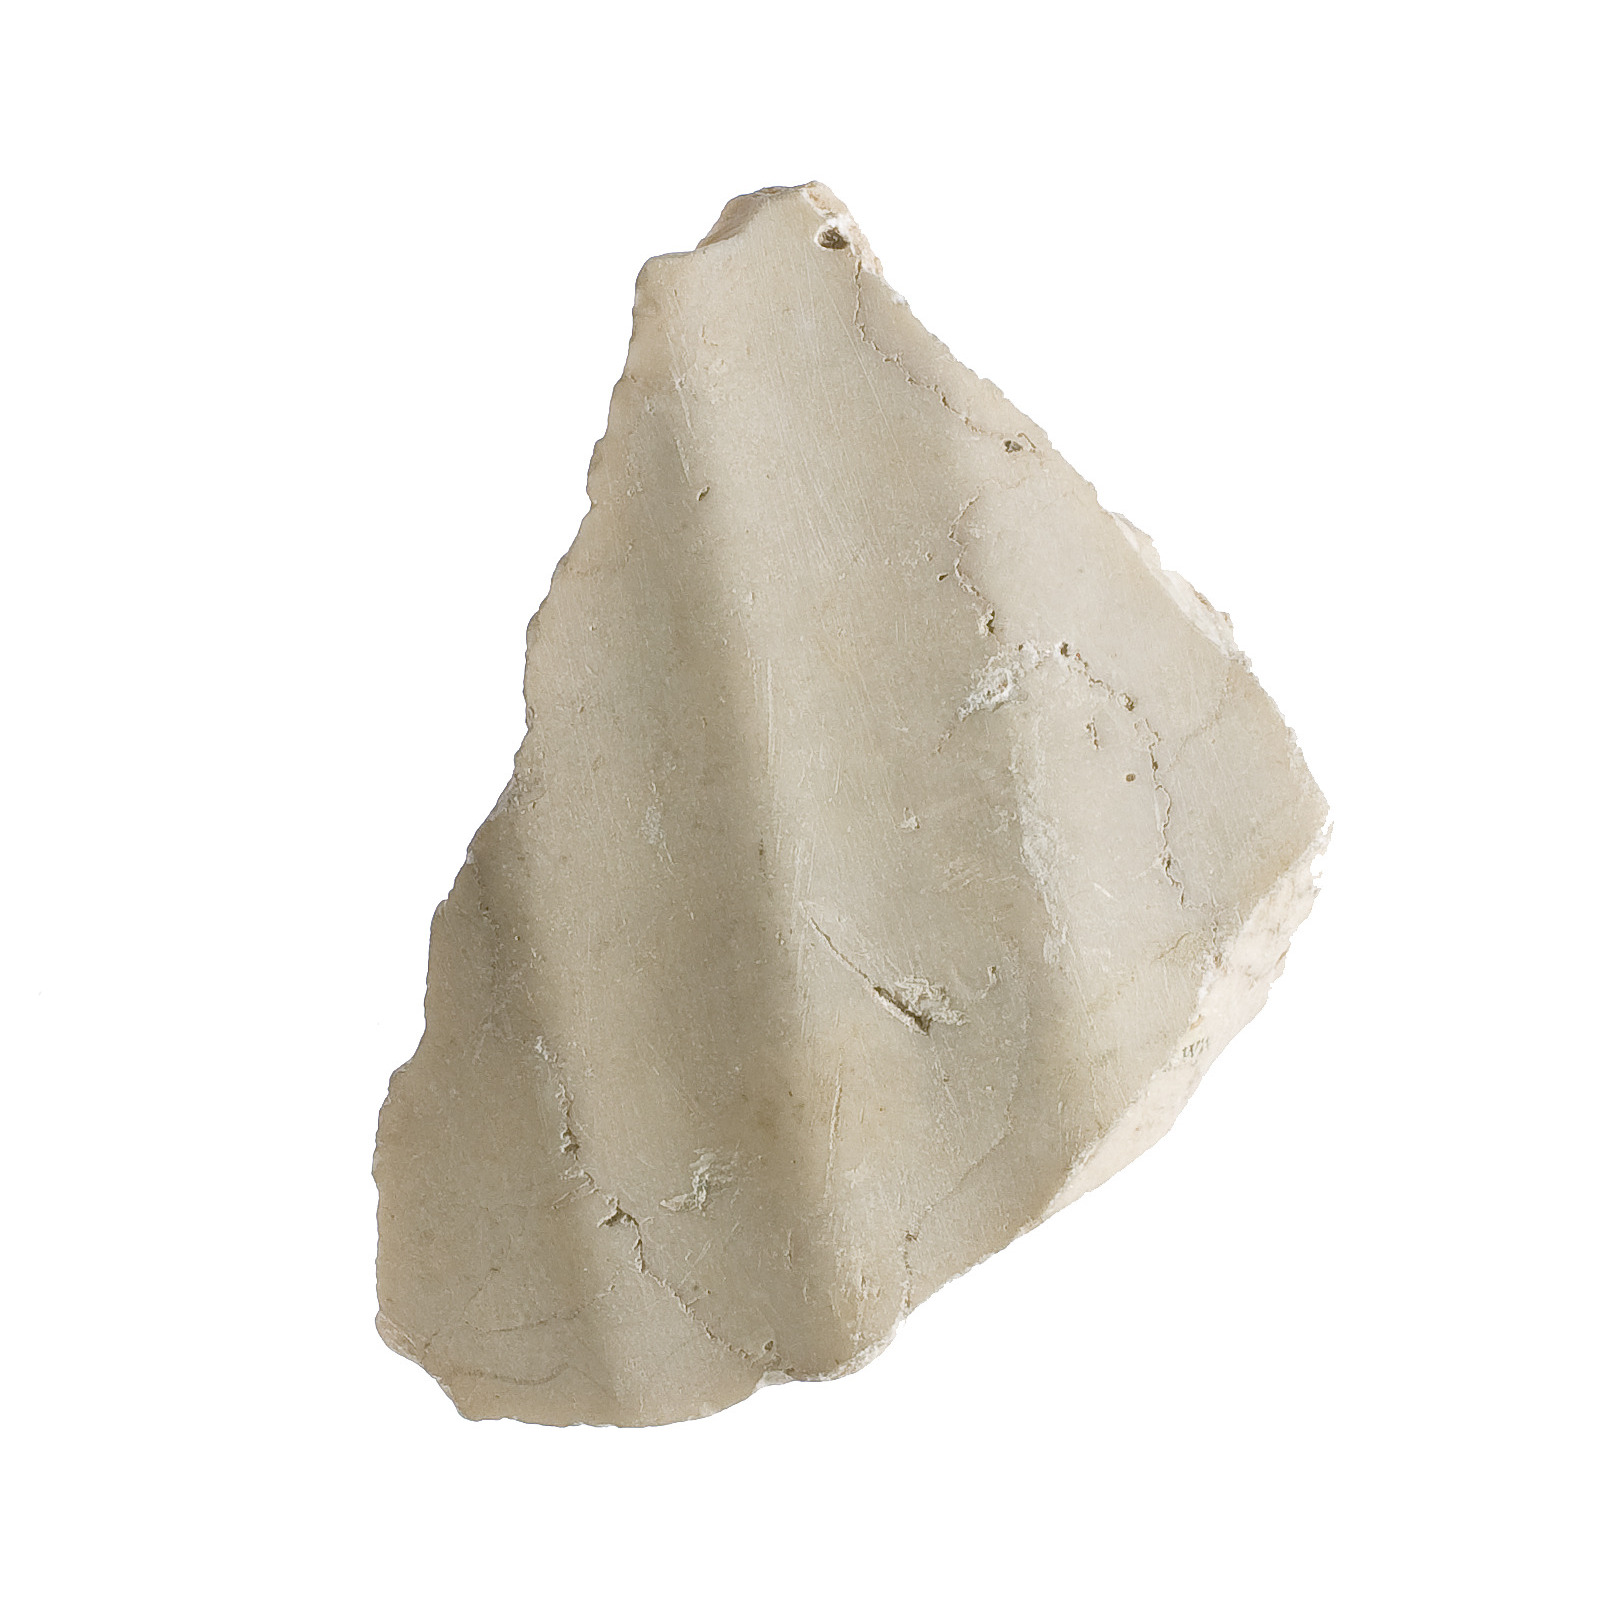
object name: body with garment, pleating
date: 1353-1336 BCE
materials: limestone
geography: egypt